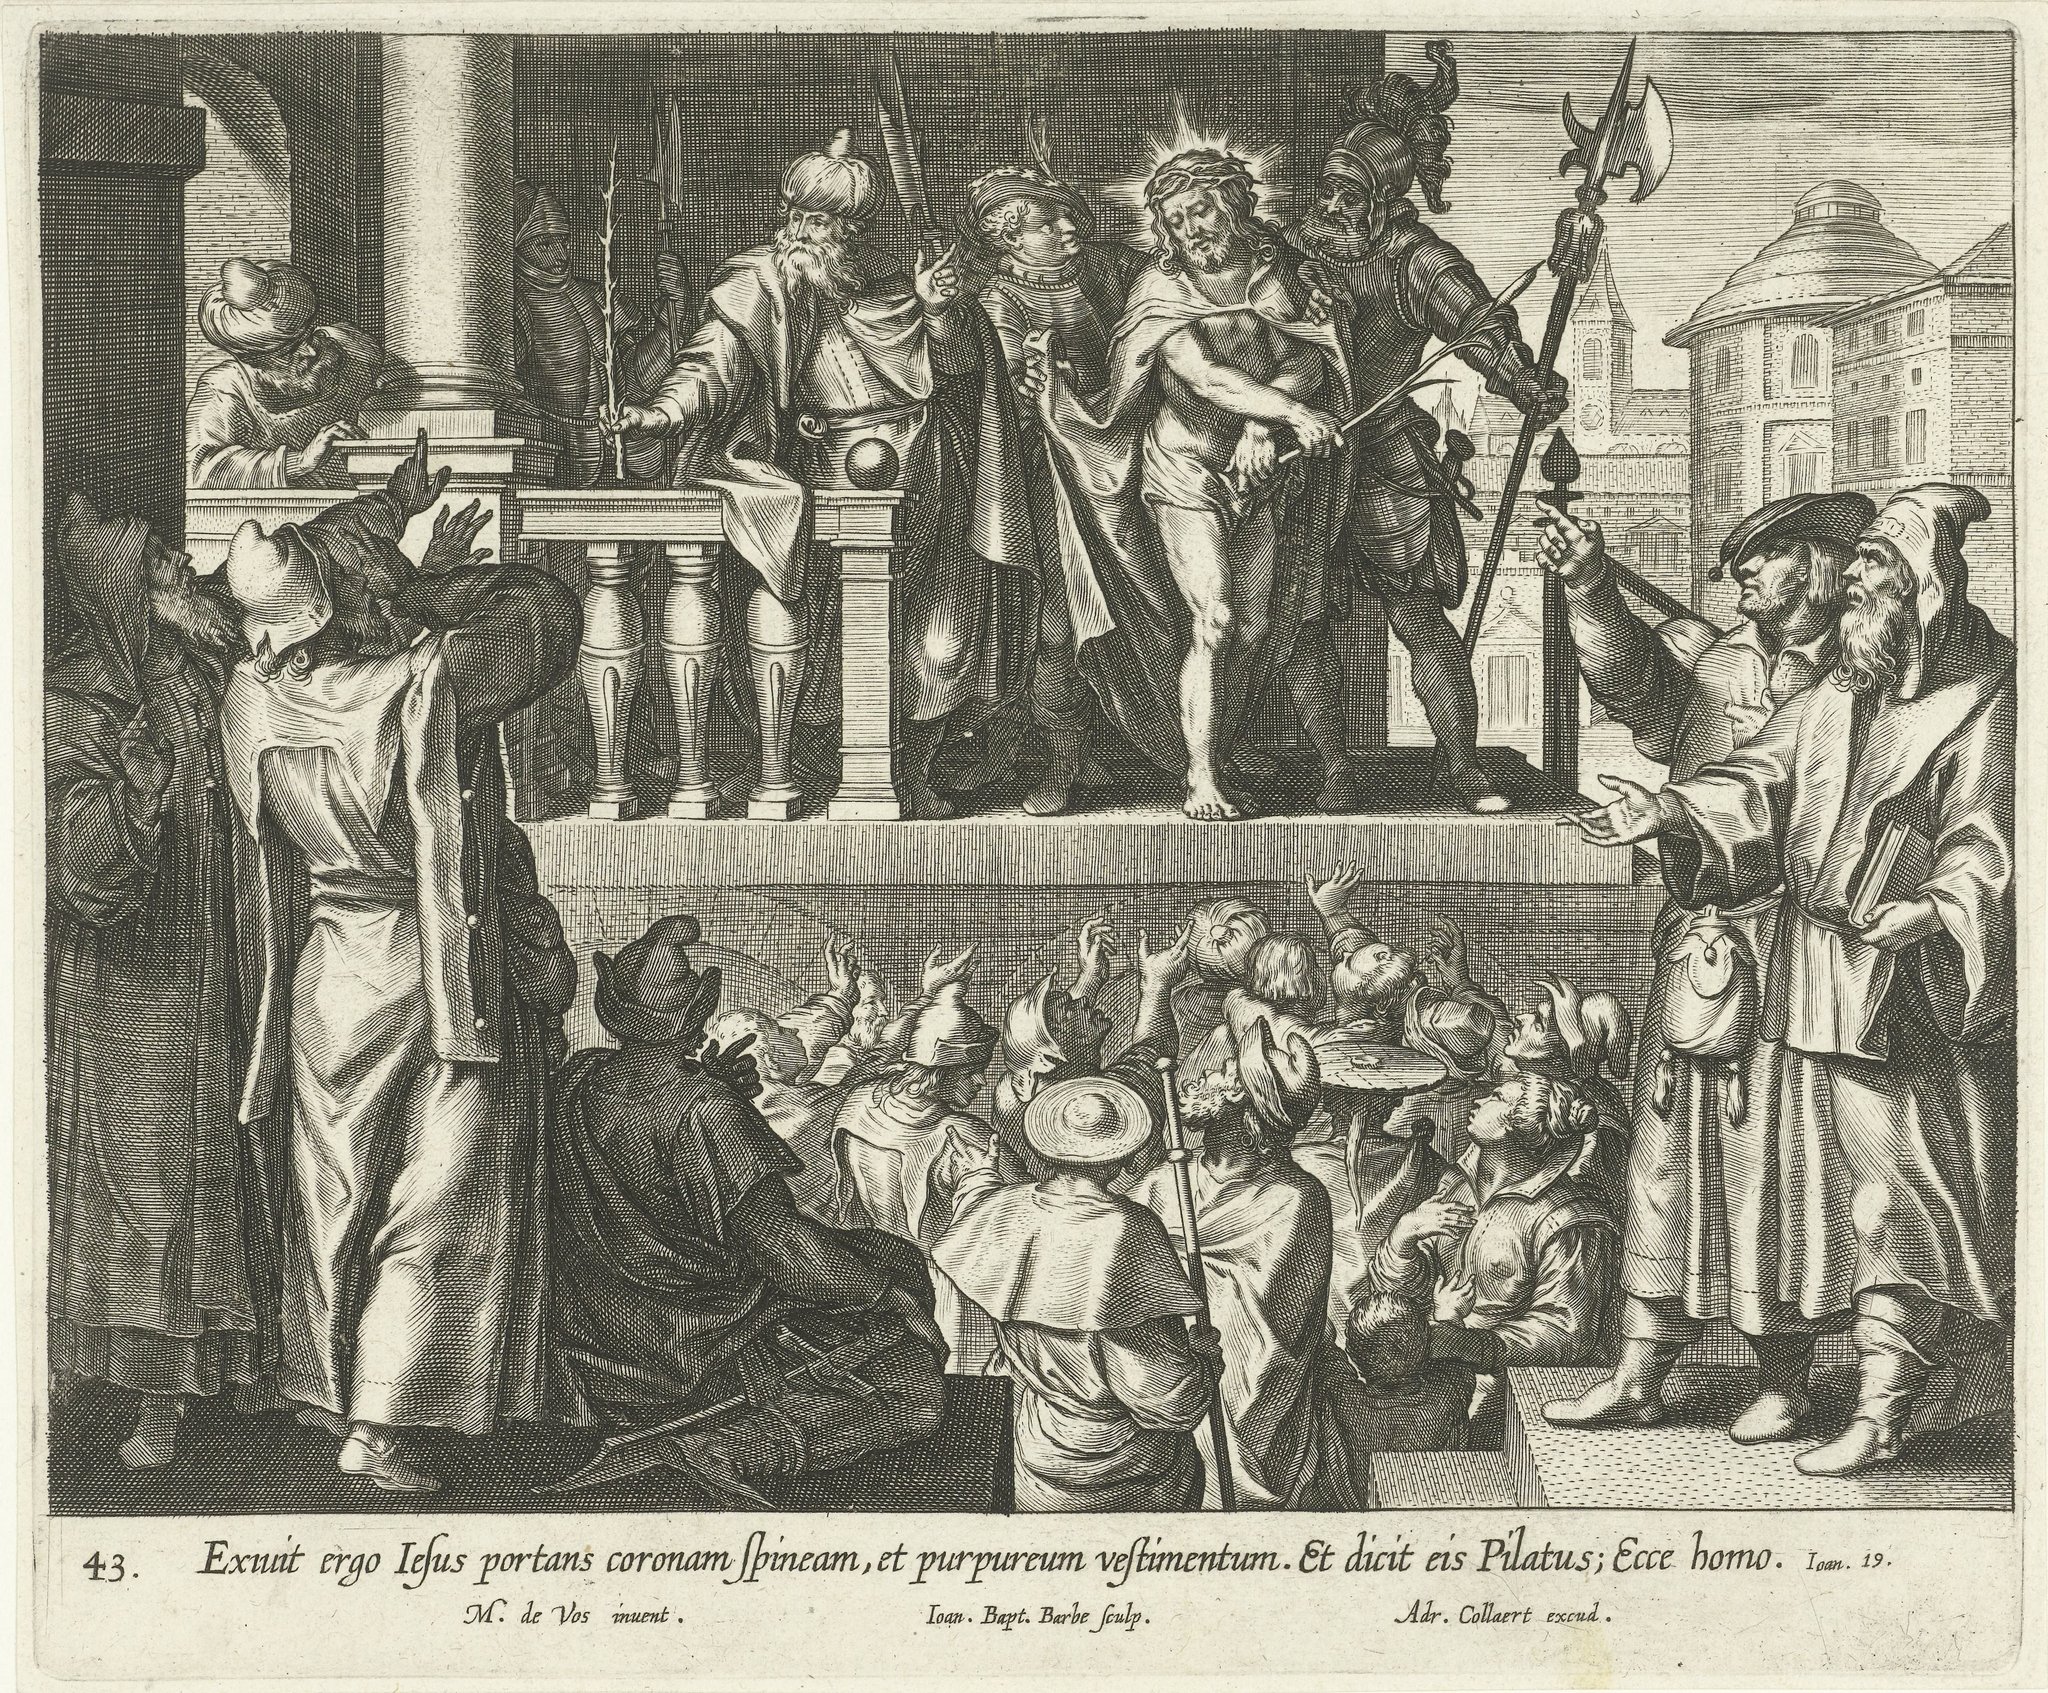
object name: print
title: Ecce Homo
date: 1598-1618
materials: paper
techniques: engraving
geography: antwerp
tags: pilate showing christ to the people, 'ostentatio christi', 'ecce homo' (john 19:4-6)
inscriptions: collector's mark: Lugt 2228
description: Pontius Pilatus toont de gegeselde Christus aan het Joodse volk (Johannes 19:4-7). De prent heeft een Latijns onderschrift. De prent maakt deel uit van een serie over het leven van Christus.